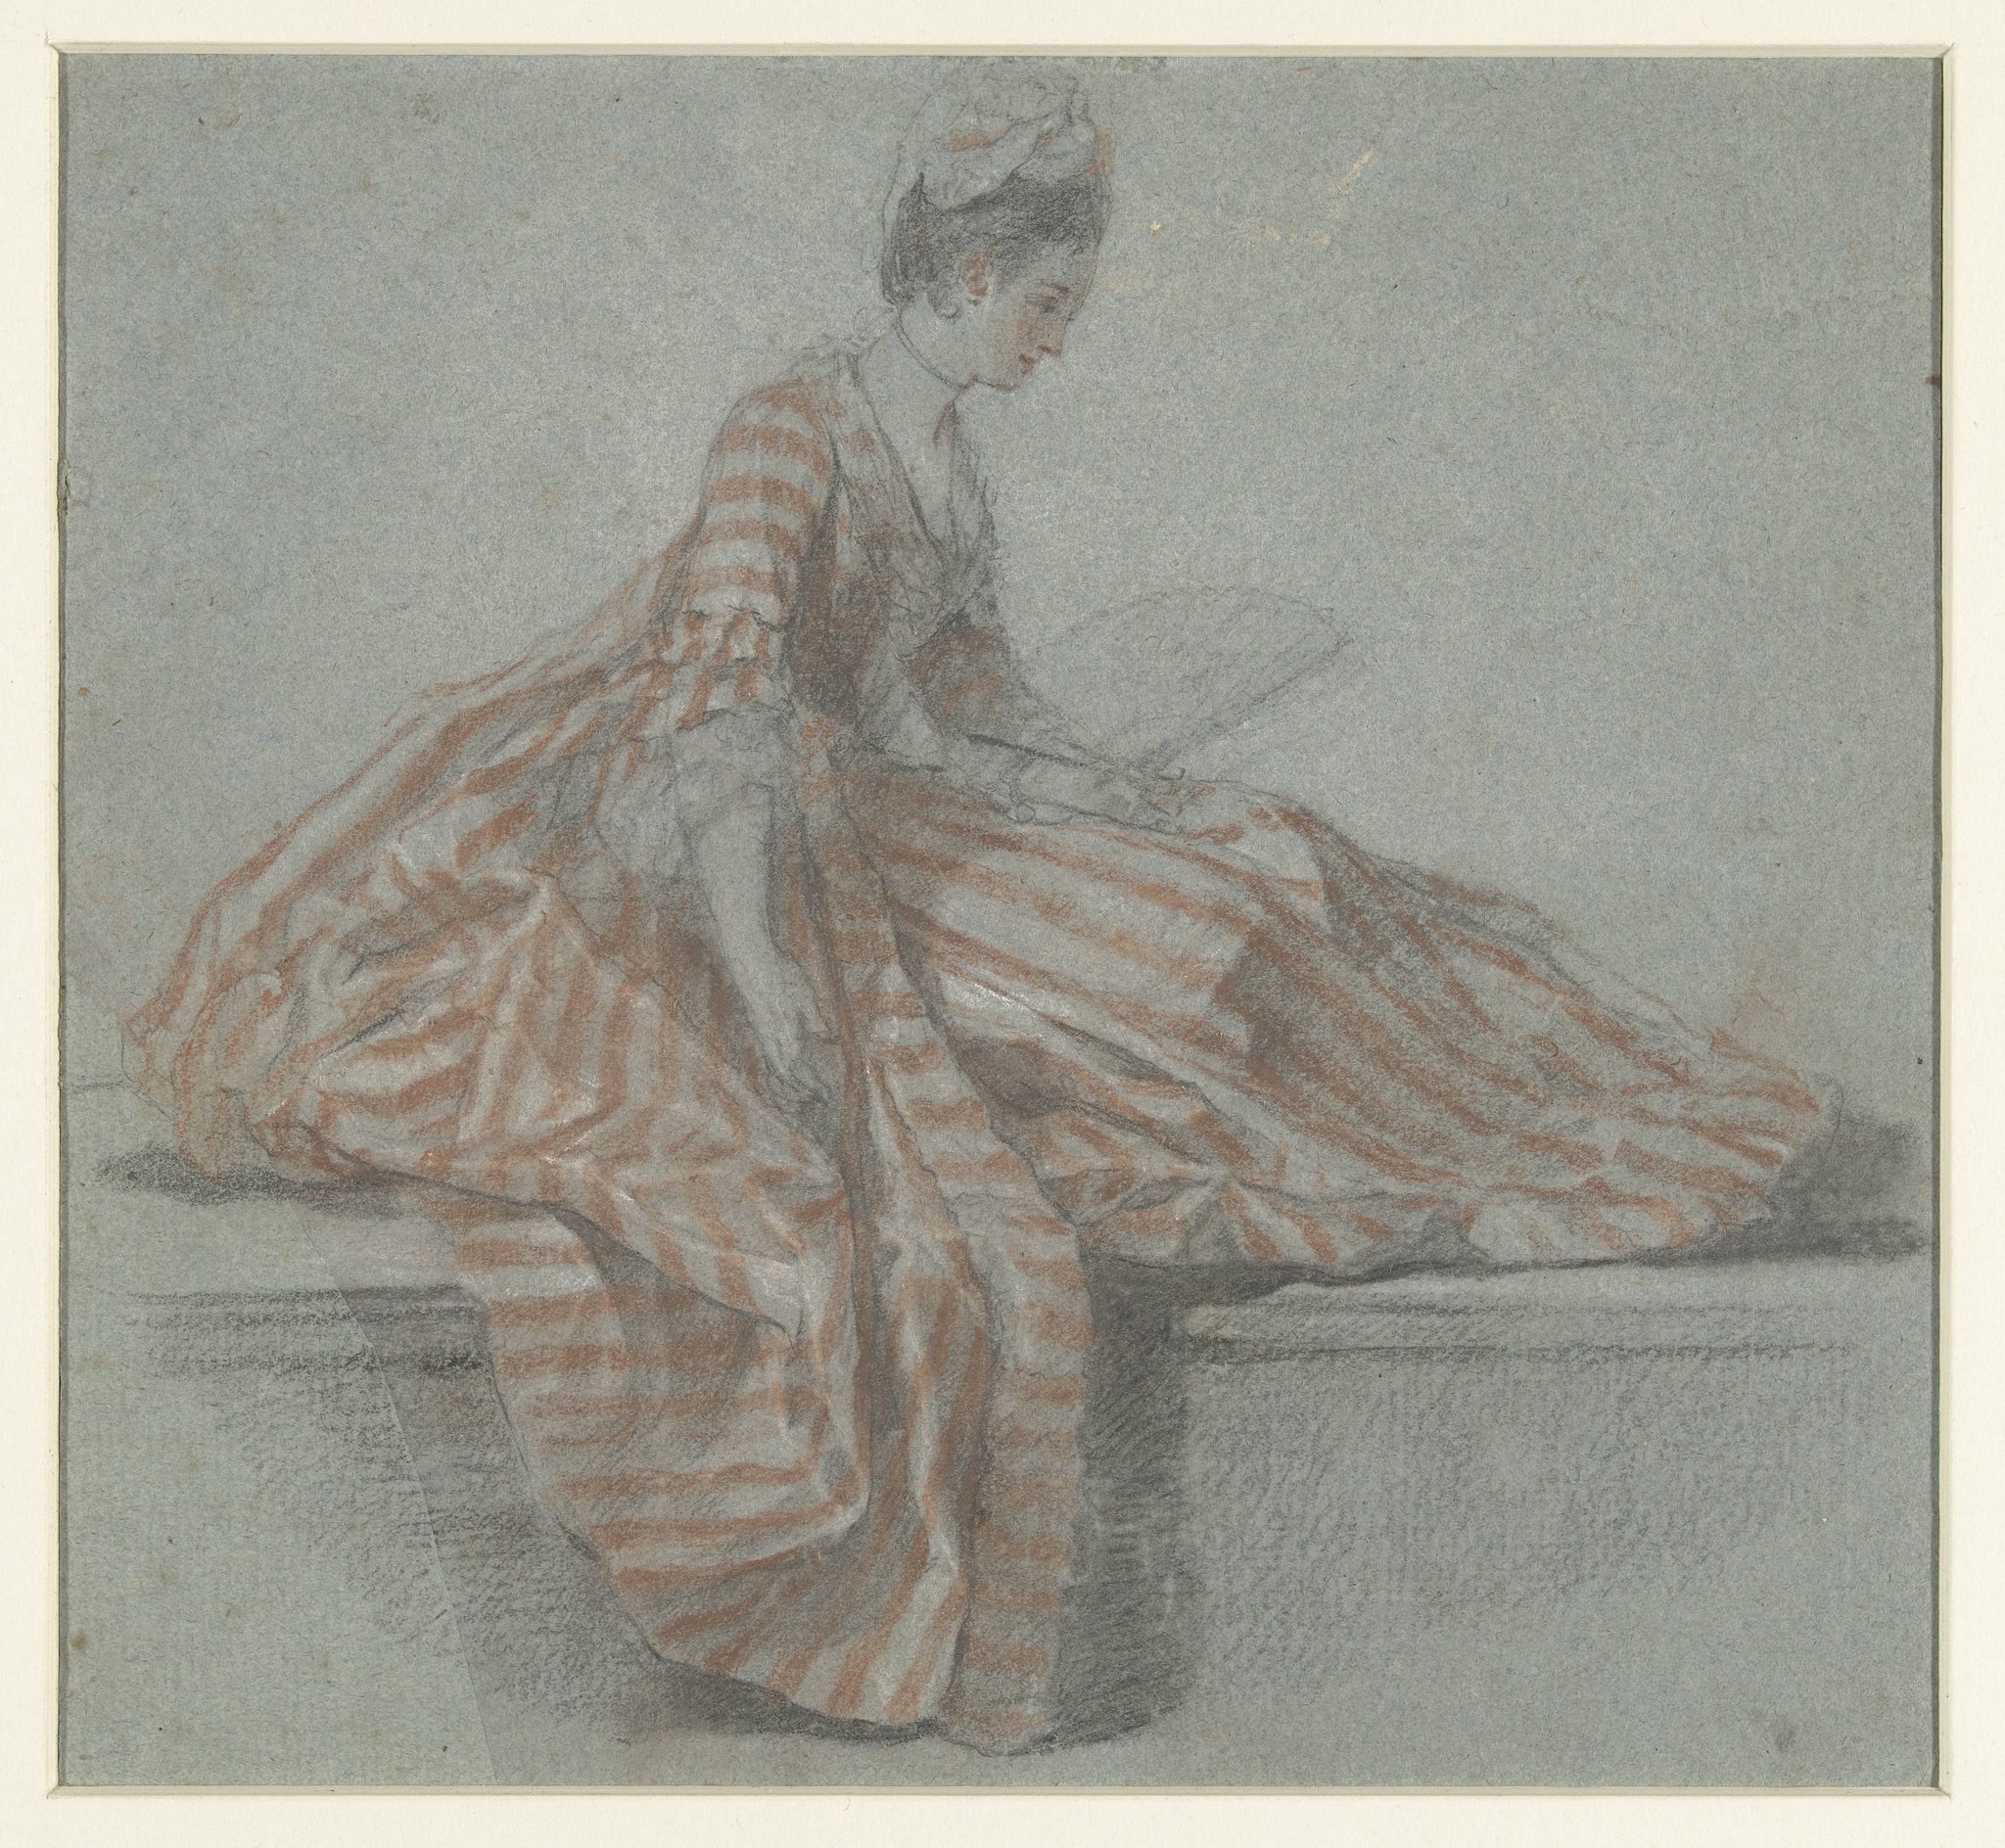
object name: drawing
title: Zittende dame op een balustrade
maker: michel barthélémy ollivier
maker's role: draughtsman, print maker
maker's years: 1712-1784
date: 1722-1784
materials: chalk, paper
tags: sitting figure - aa - female human figure, fan, dress, gown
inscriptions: collector's mark, verso, lower centre: Lugt 2228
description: Zittende dame met een waaier op een balustrade.